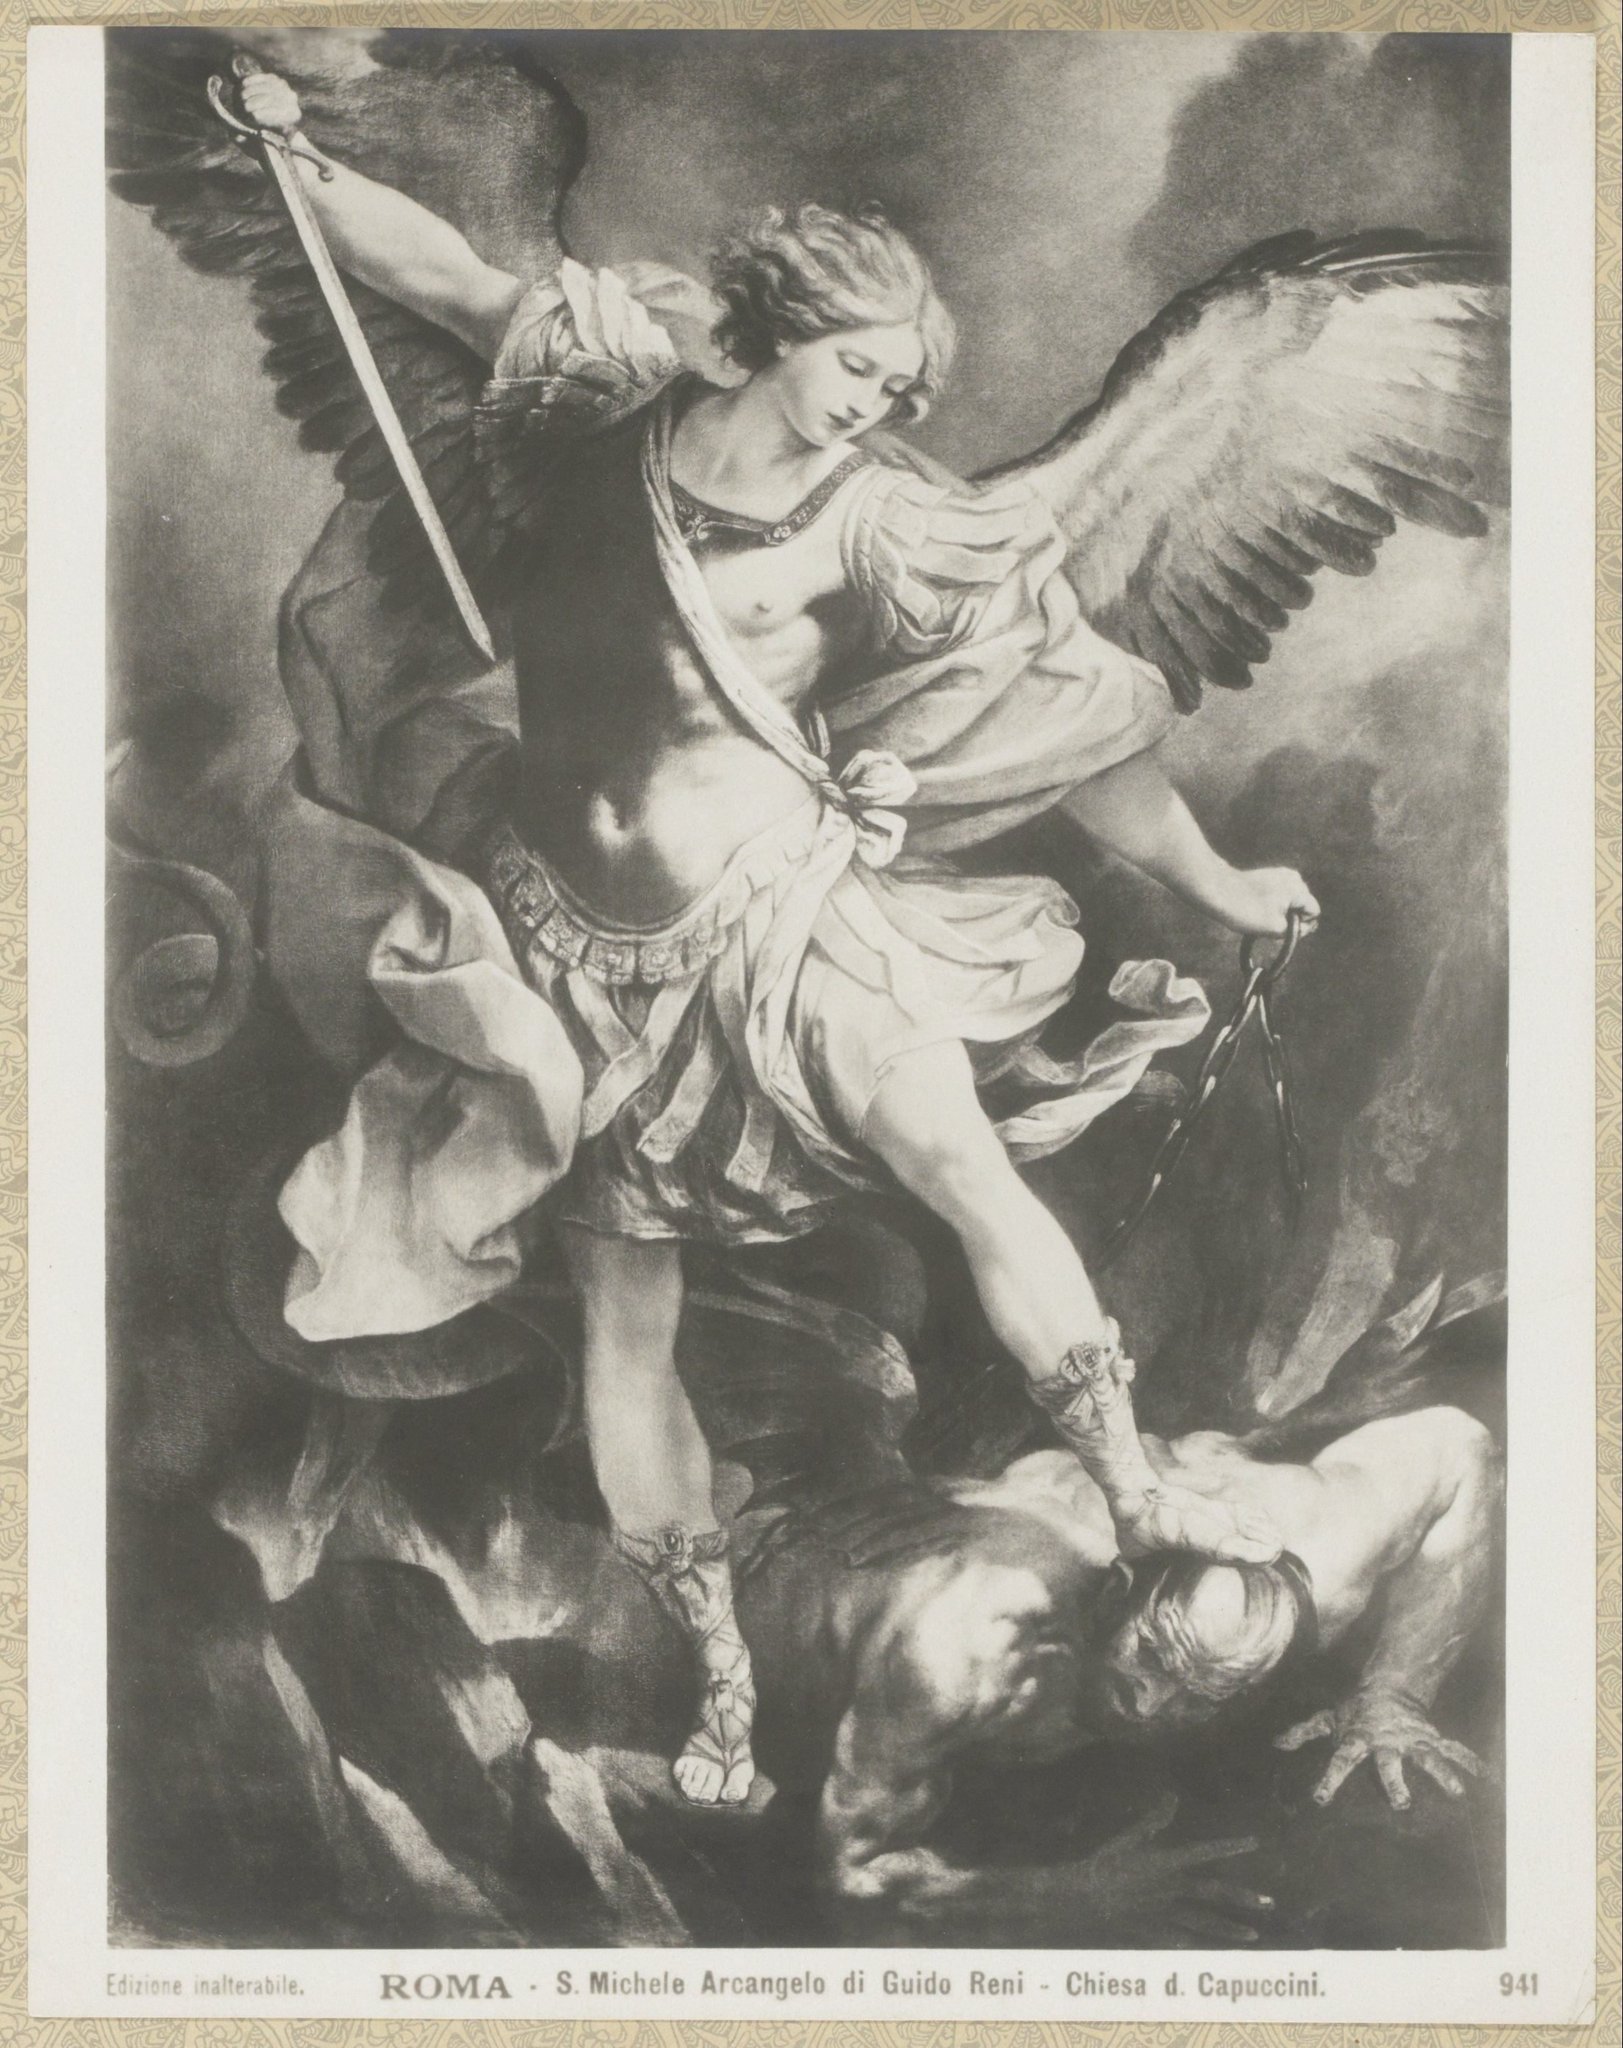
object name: photograph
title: ROMA - S. Michele Arcangelo di Guido Reni - Chiesa d. Capuccini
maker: Anonymous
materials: photographic support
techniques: gelatin silver print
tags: the archangel michael fighting the dragon (devil, satan)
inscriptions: inscription: ‘Edizione inalterabile’, number: ‘941’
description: Onderdeel van Fotoalbum van een reis door Zuid-Europa en het Midden-Oosten.